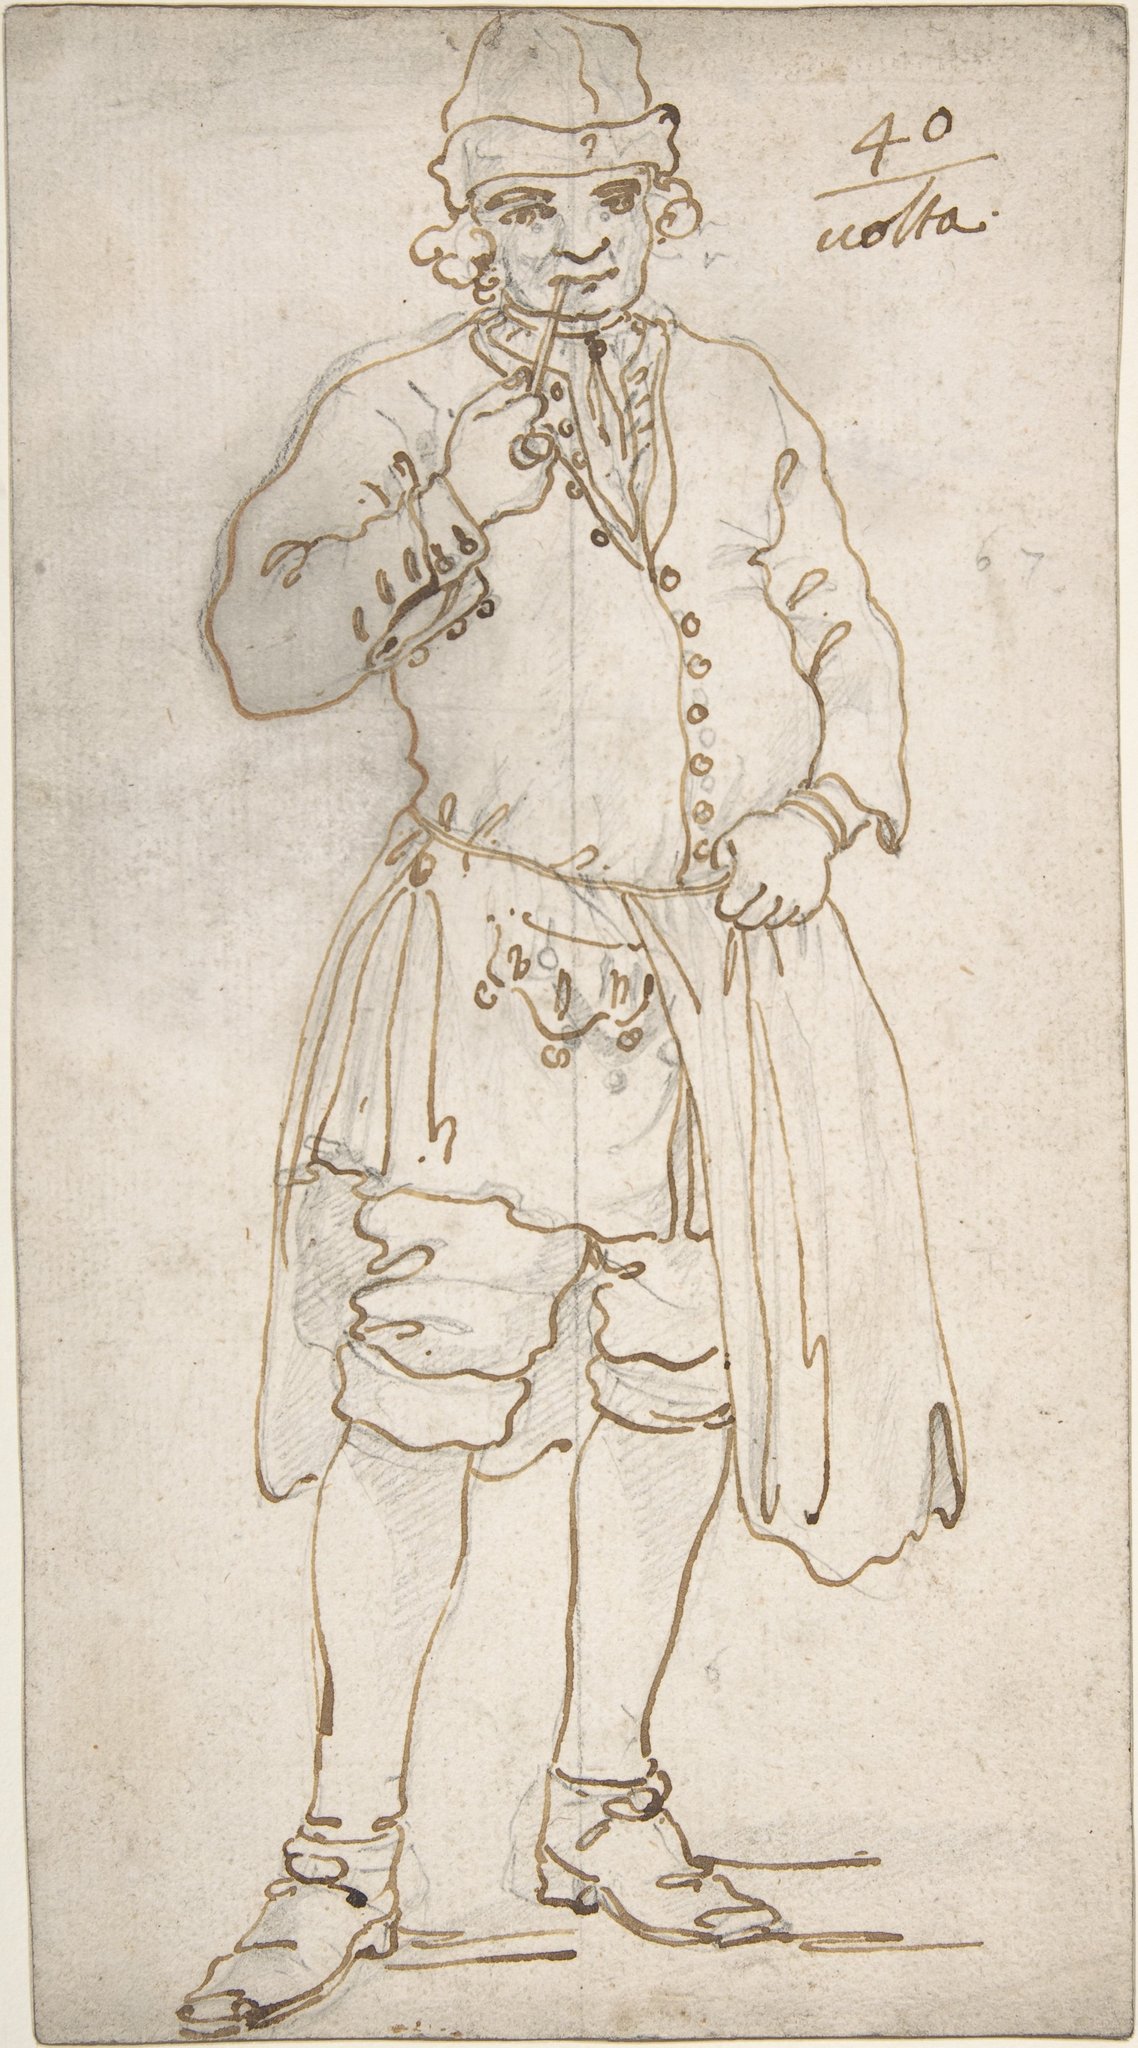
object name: drawing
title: Man Smoking a Pipe (recto); Standing Man and Two Studies of His Head (verso)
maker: canaletto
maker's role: artist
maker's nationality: italian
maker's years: 1697-1768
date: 1697-1768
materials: graphite, ink, lead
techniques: pen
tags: men,smoking